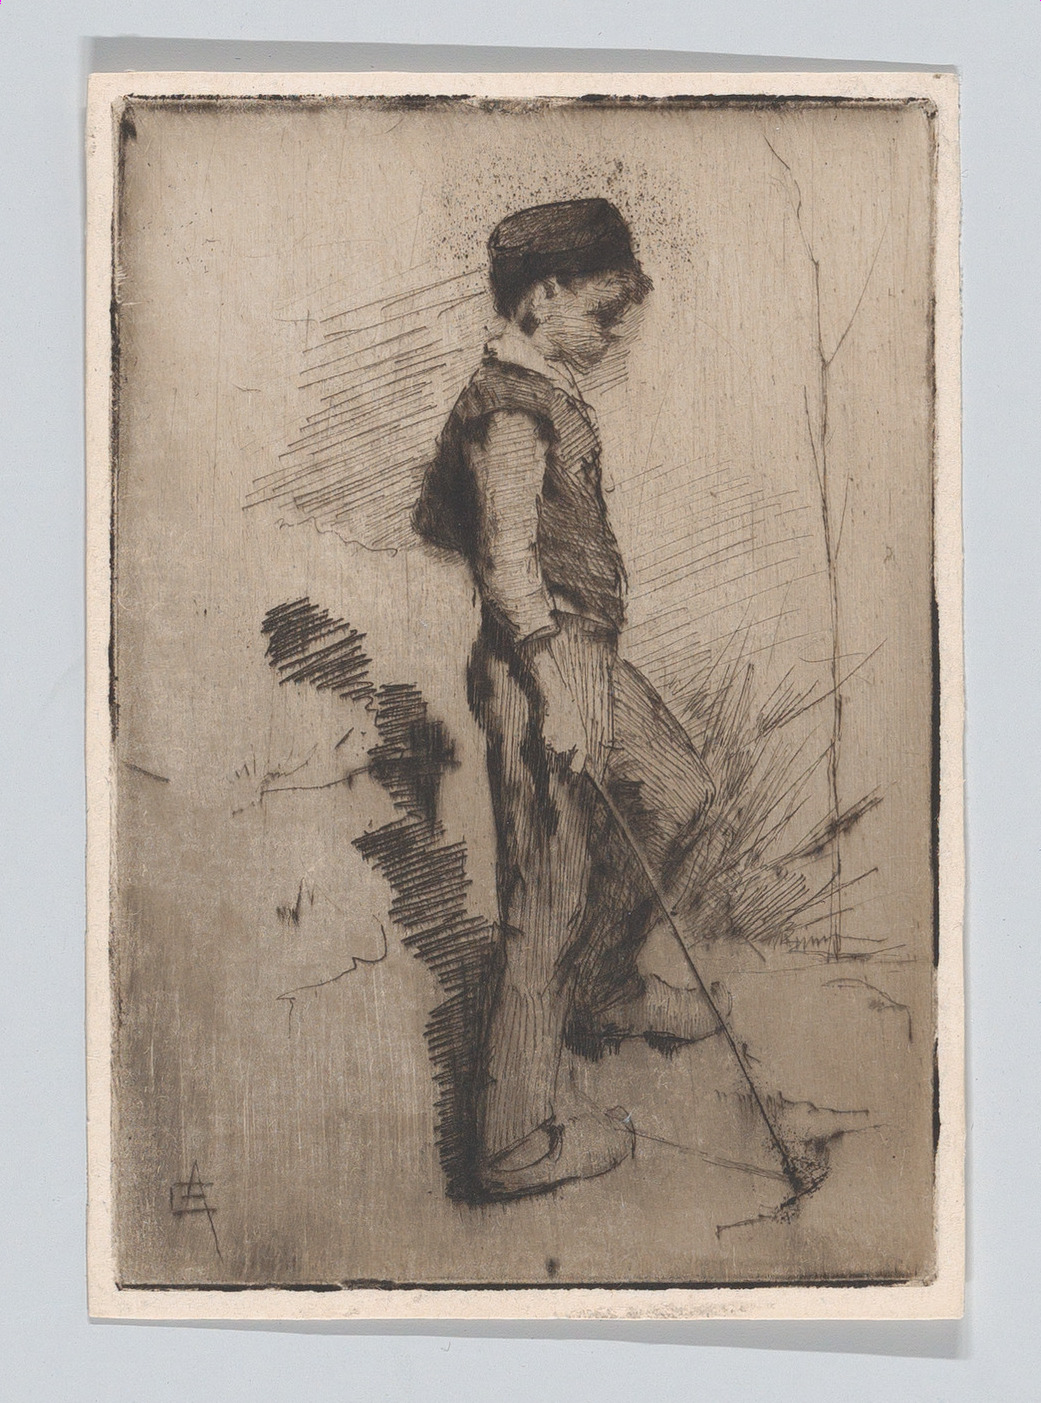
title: Boy with a Stick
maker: elizabeth forbes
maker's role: artist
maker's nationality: british, born canada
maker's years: 1859-1912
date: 1881-1883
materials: ink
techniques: drypoint, etching, printing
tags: boys